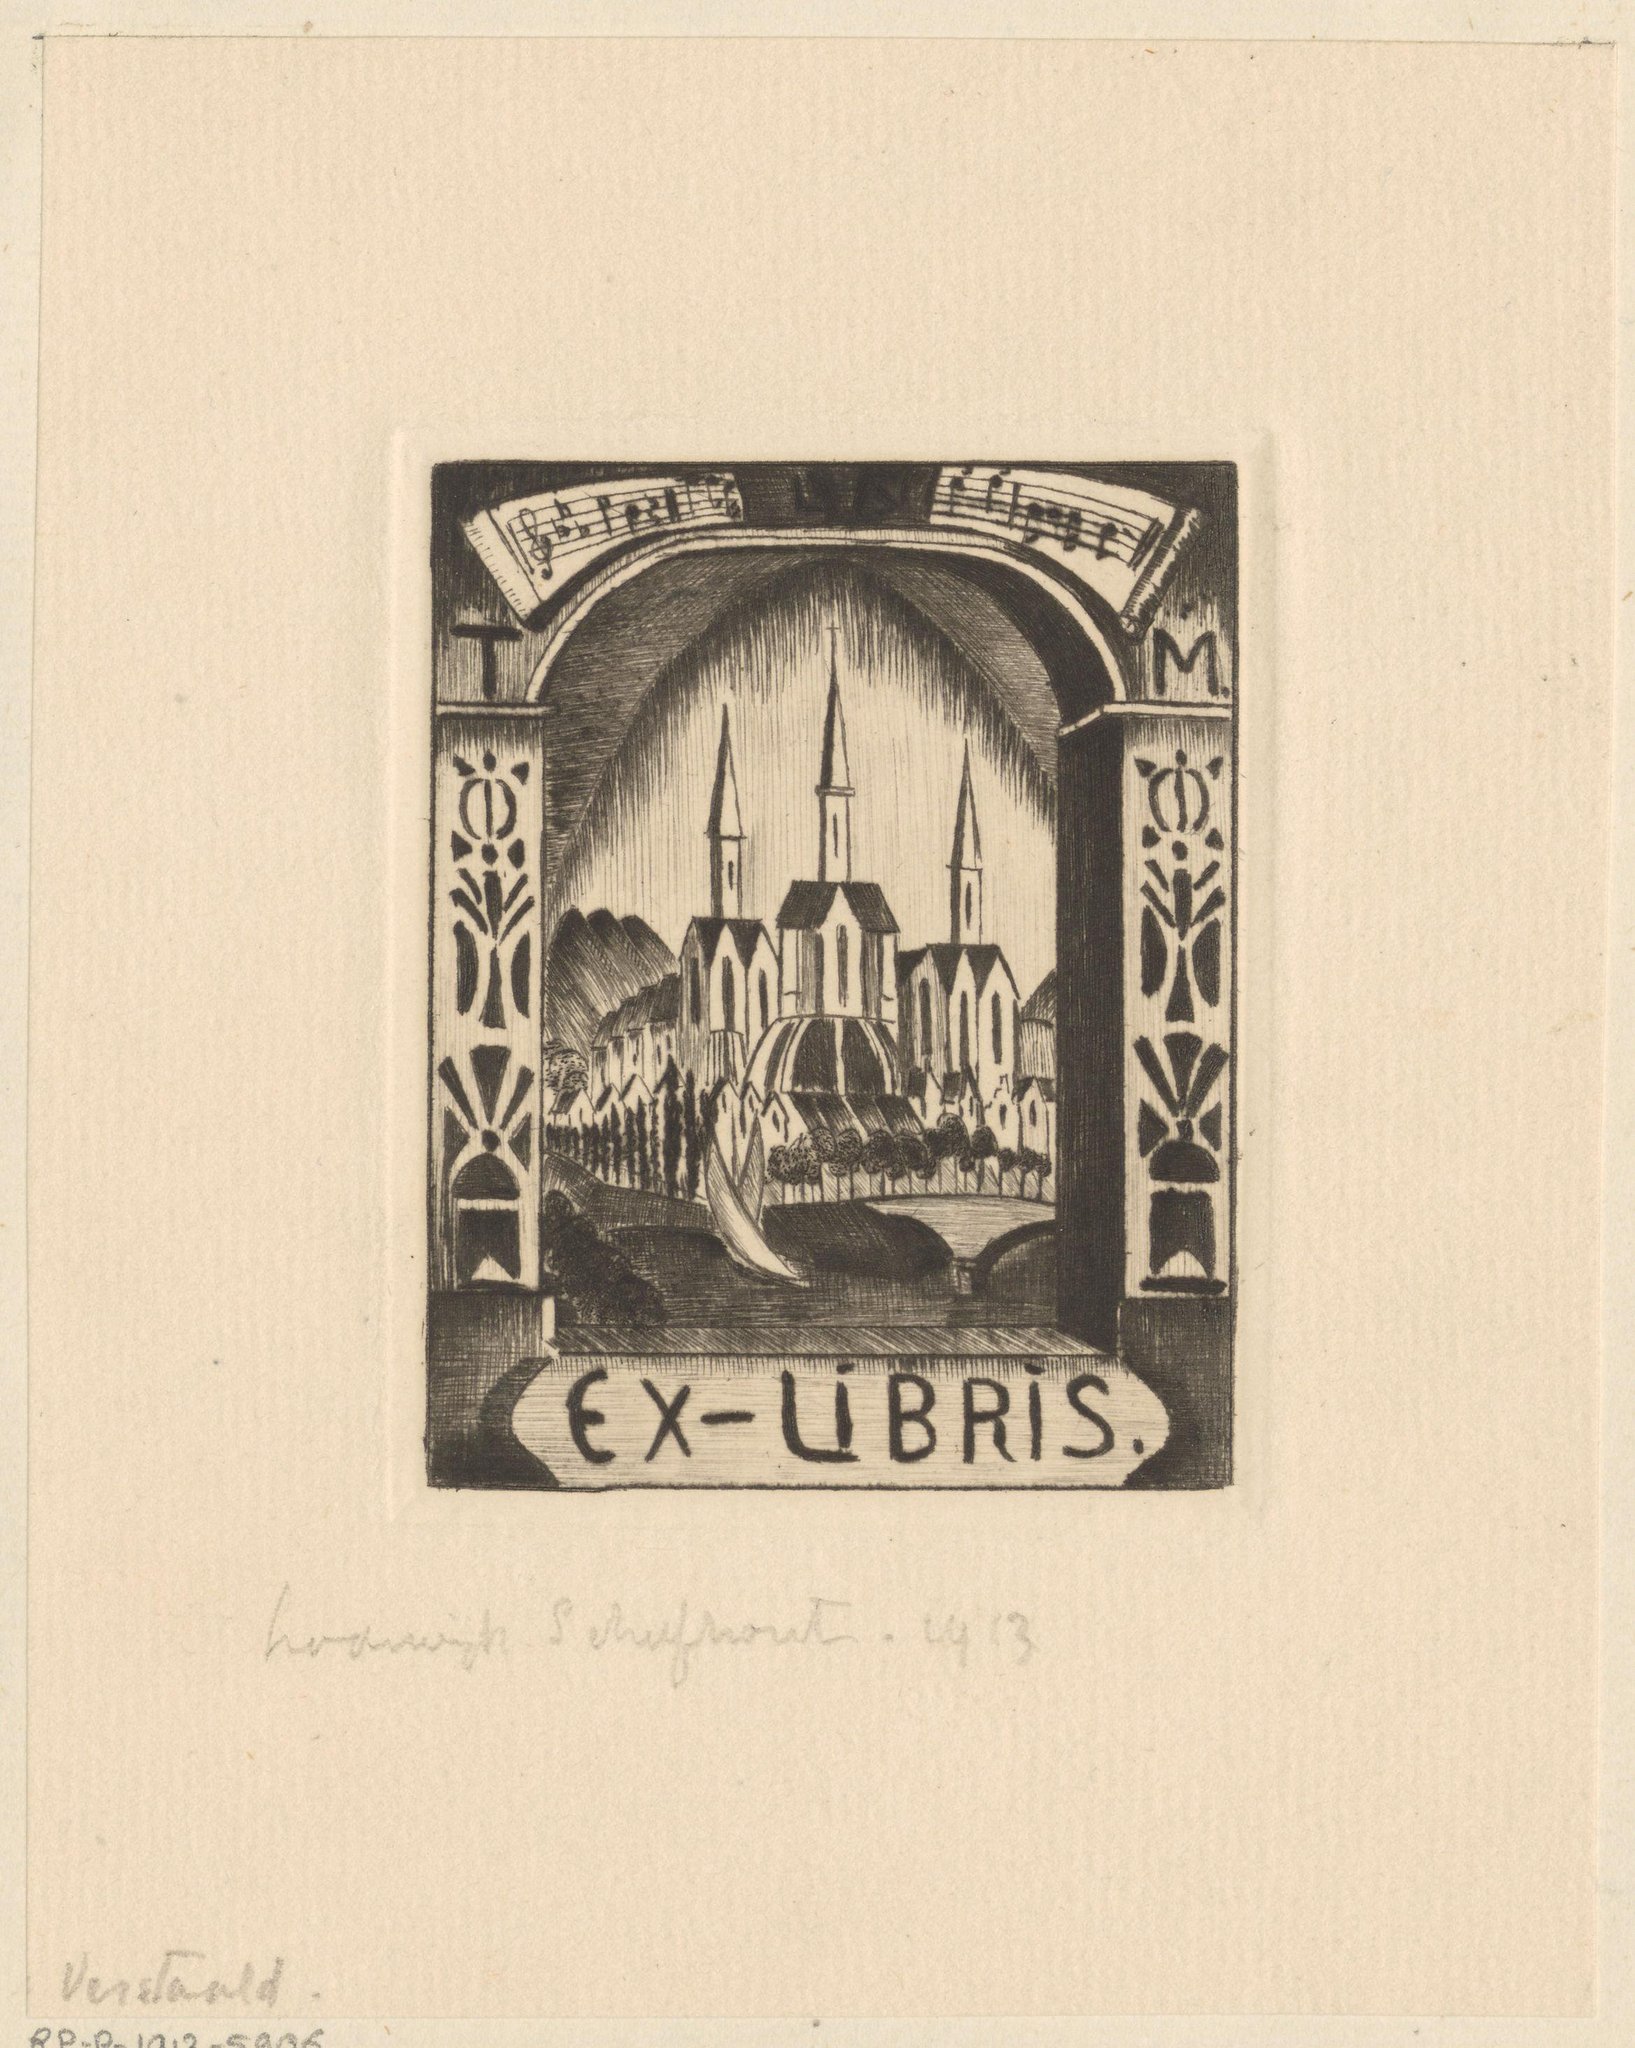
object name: bookplate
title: Ex libris van T. Mengelberg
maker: lodewijk schelfhout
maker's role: draughtsman, print maker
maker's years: 1881-1943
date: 1913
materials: paper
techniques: etching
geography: netherlands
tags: the christian churches, notation of music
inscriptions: collector's mark: Lugt 2233, inscription: ‘Lodewijk Schelfhout. 1913’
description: Op het opzetvel wordt de naam Mengelberg vermeld, wat een aanknopingspunt kan zijn voor het achterhalen van de identiteit van de opdrachtgever.